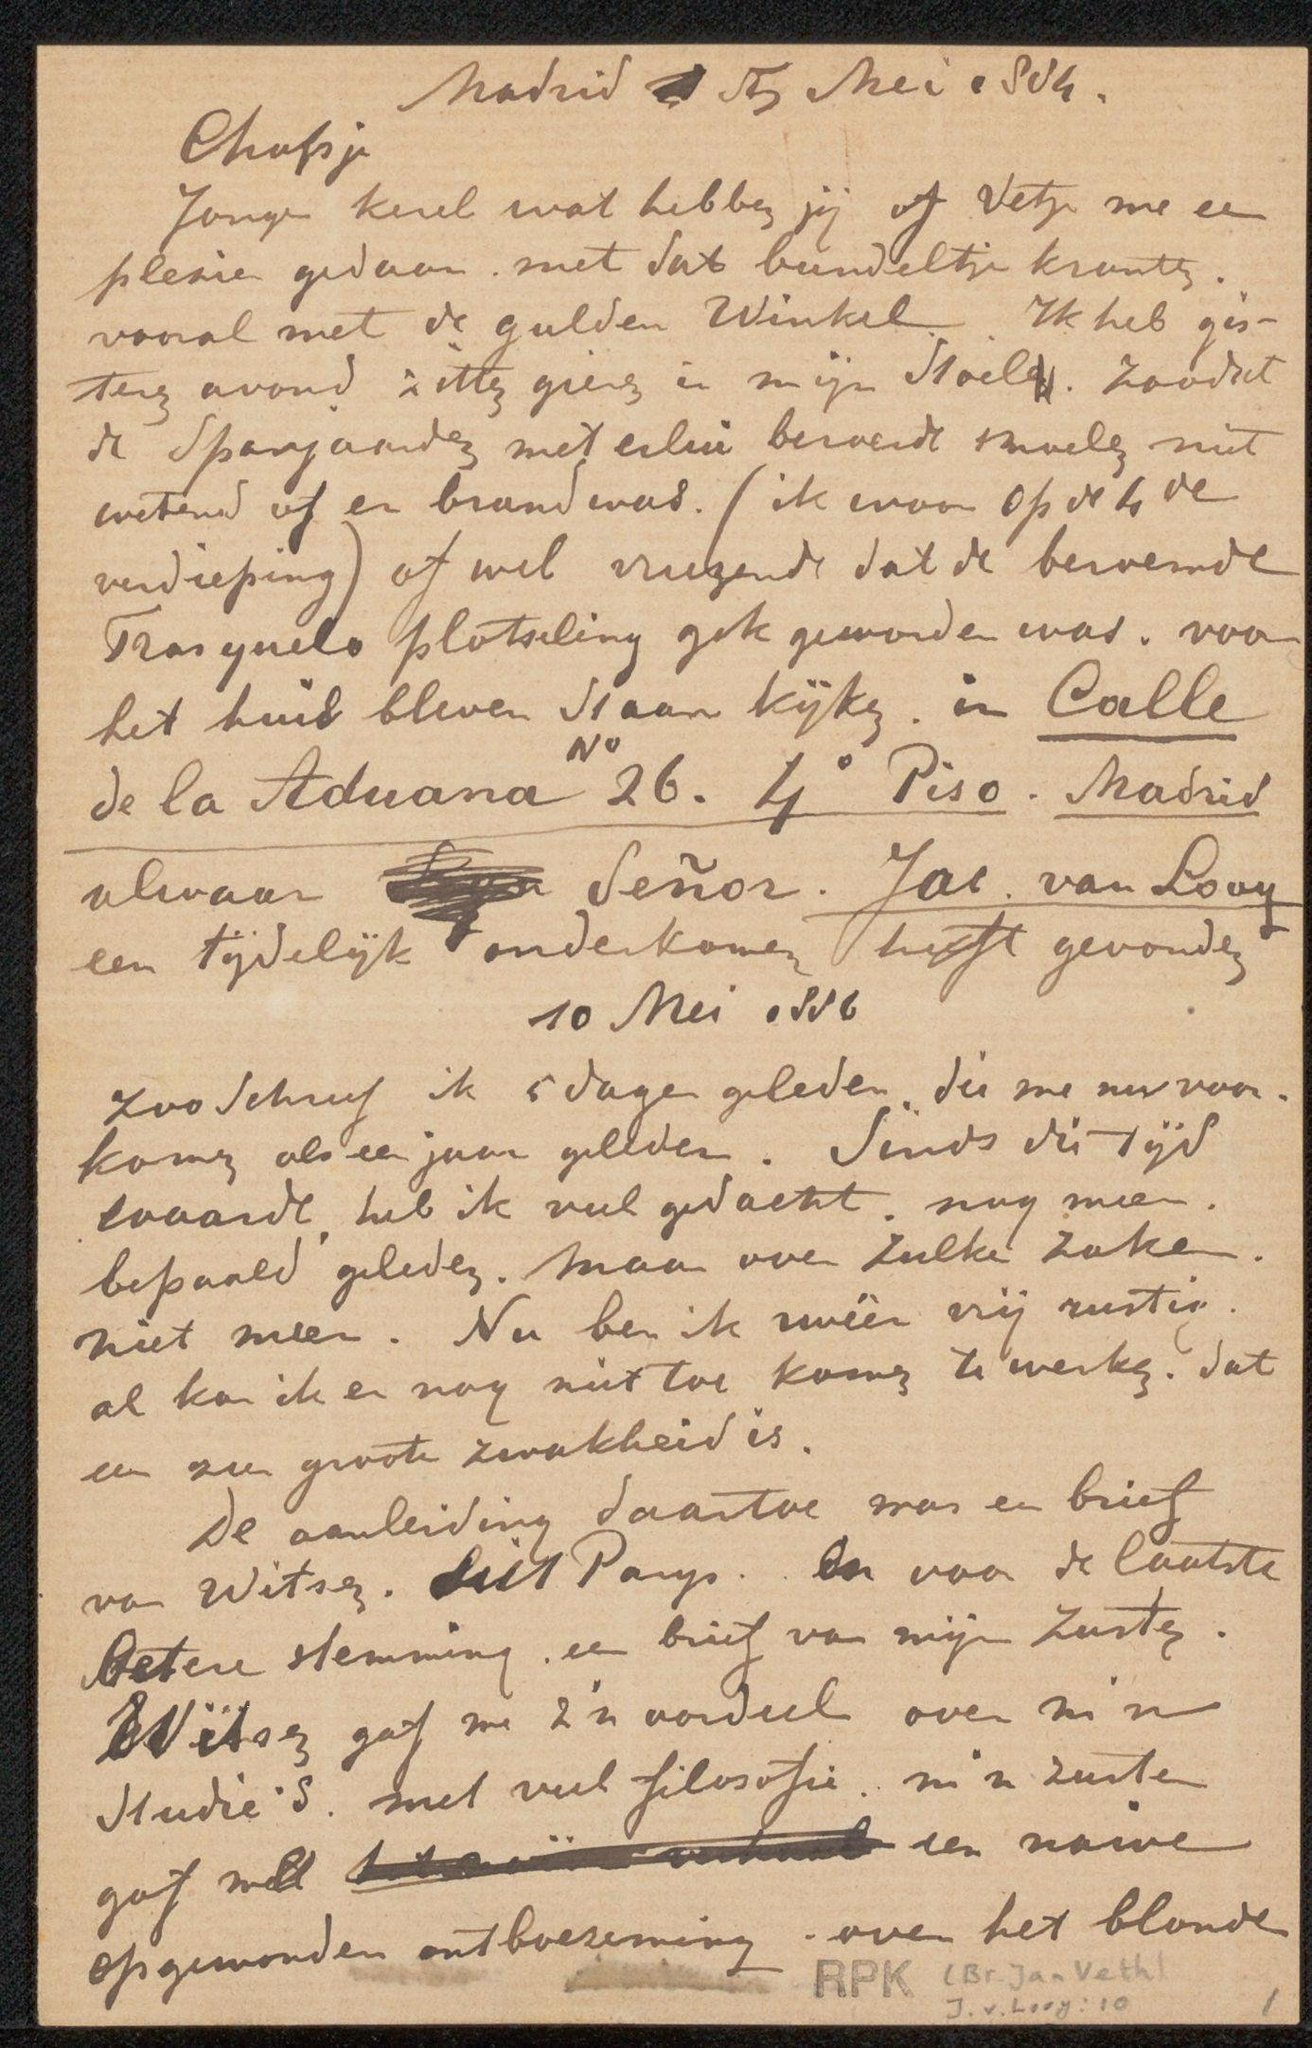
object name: letter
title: Brief aan Chap van Deventer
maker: jac van looij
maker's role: draughtsman, painter, print maker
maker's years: 1855-1930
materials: ink, paper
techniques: pen, writing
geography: madrid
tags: august allebé, sevilla, painter, diego rodriguez de silva y velázquez, dordrecht, print maker, draughtsman, designer, jan veth, willem witsen, leiden, rembrandt van rijn, the hague, willem kloos, chap van deventer, drawing, passions, emotions, affections, literature ~ arts, painting (including book-illumination, miniature-painting), historical persons (portraits and scenes from the life), italy, haarlem, paris, amsterdam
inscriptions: collector's mark: ‘RPK’